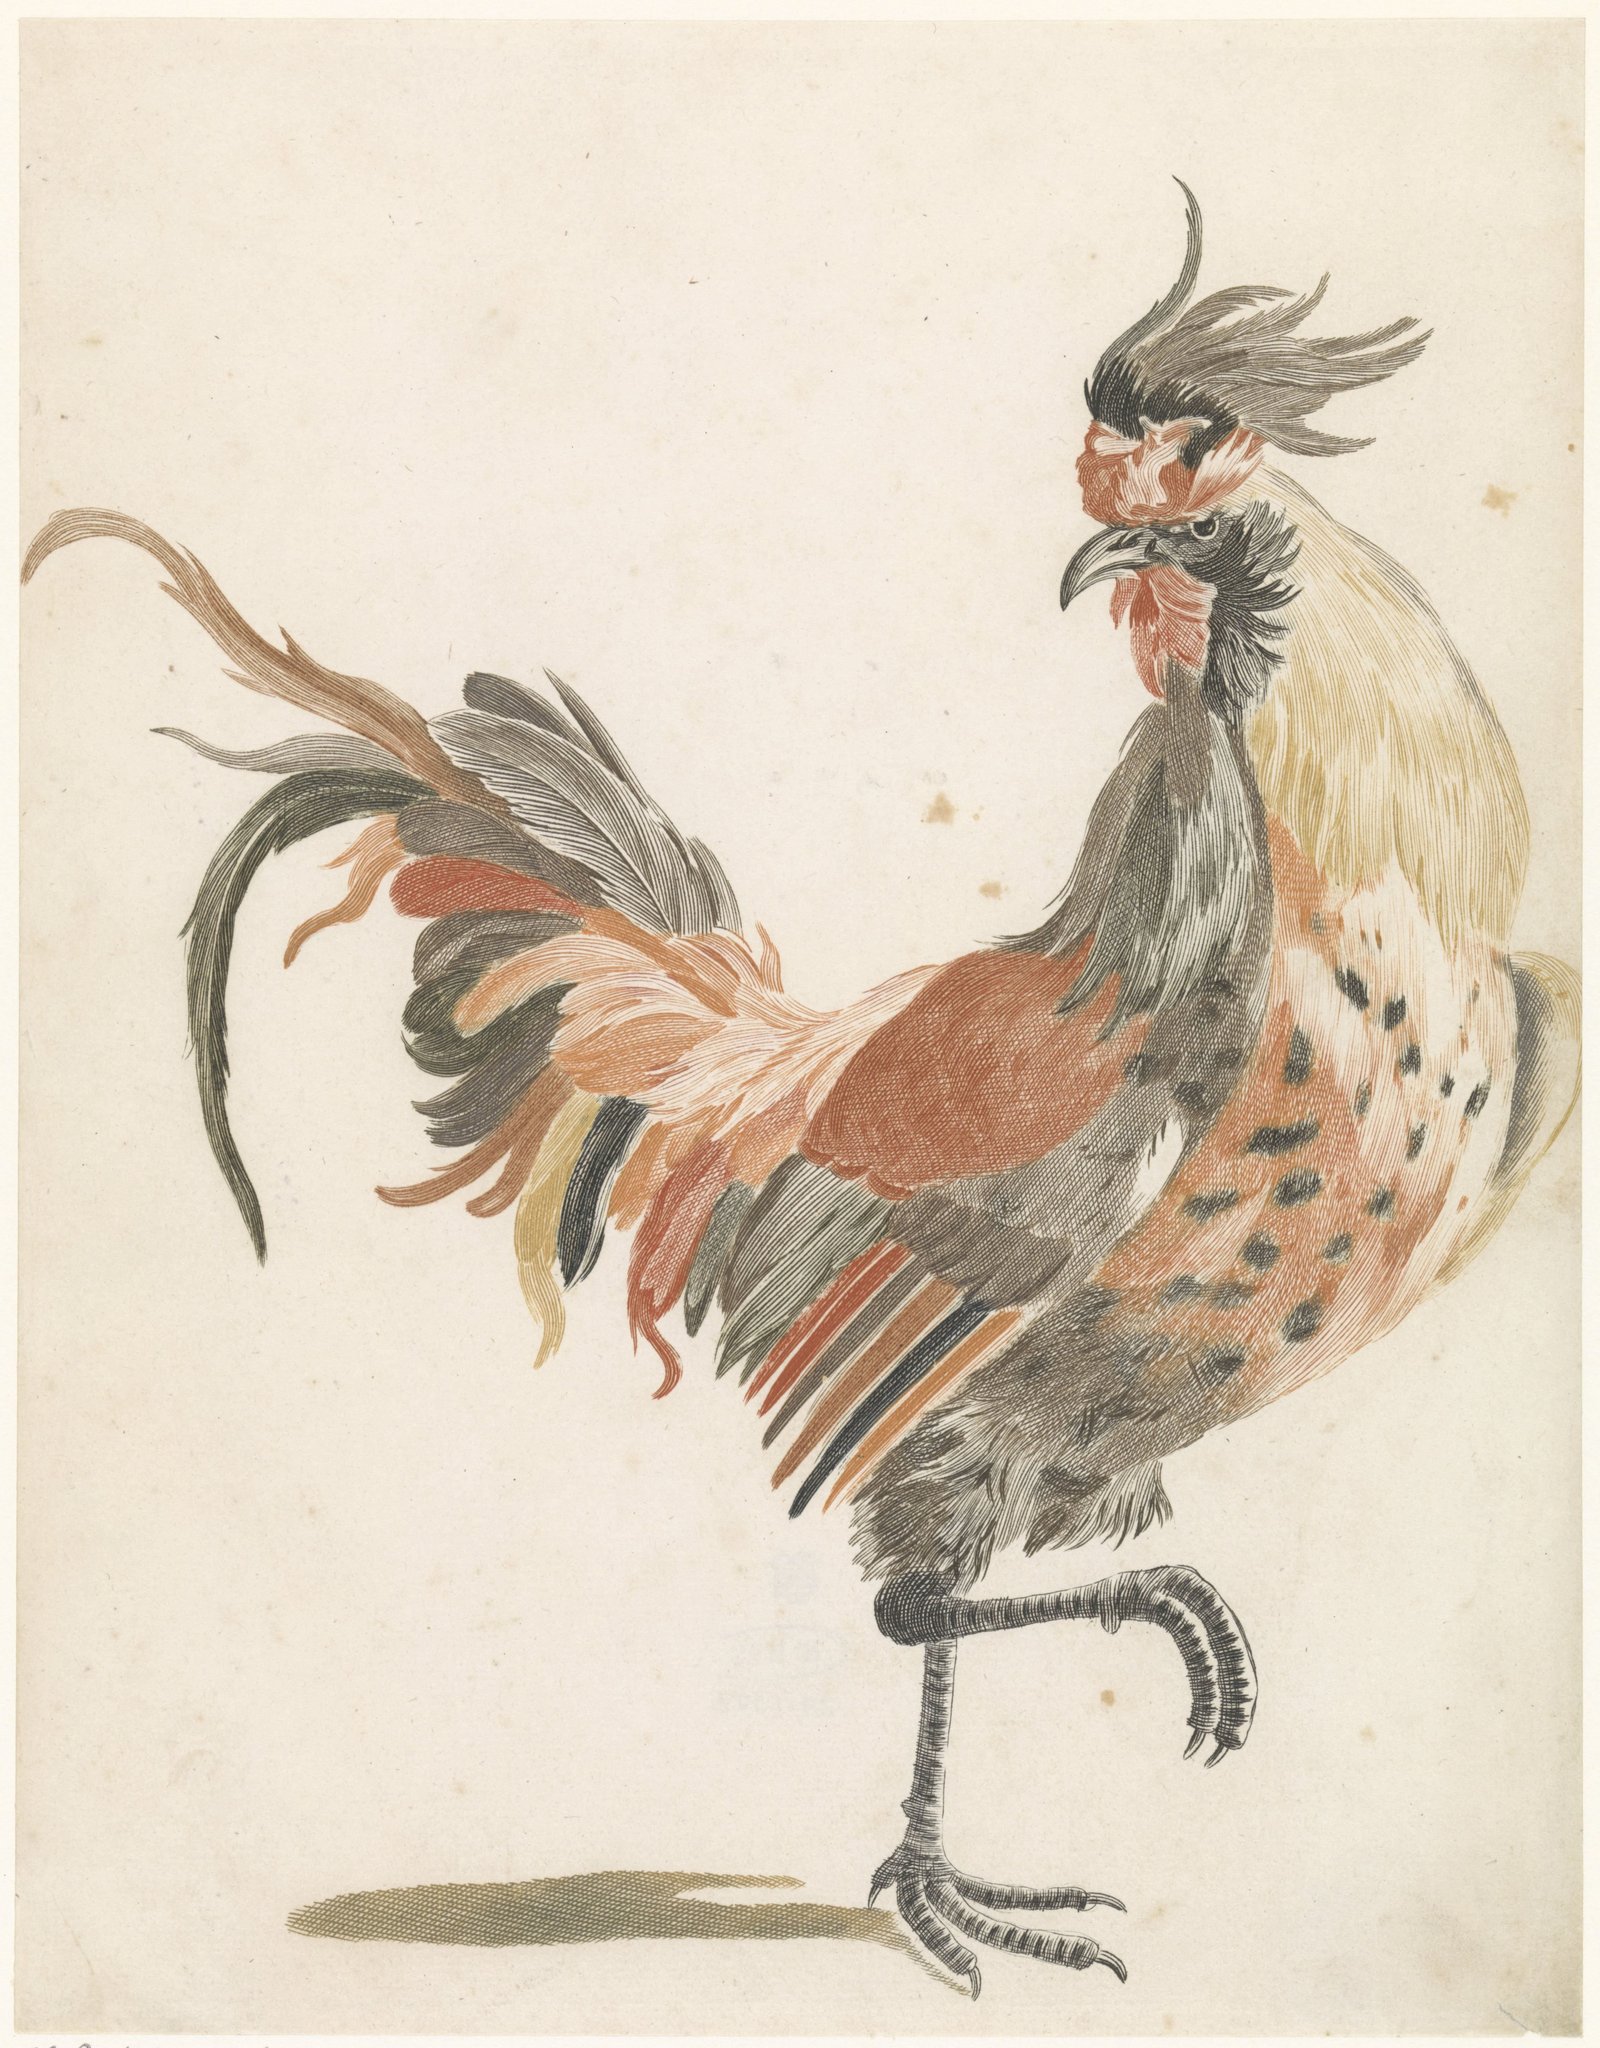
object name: print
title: Haan lopend naar rechts (versie B)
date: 1688-1698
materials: paper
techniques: printing, engraving, lithography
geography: netherlands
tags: fowl (cock, hen, chicken, etc.)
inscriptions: collector's mark: Lugt 2760, collector's mark: Lugt 2228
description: Haan, lopend naar rechts, omkijkend naar links.